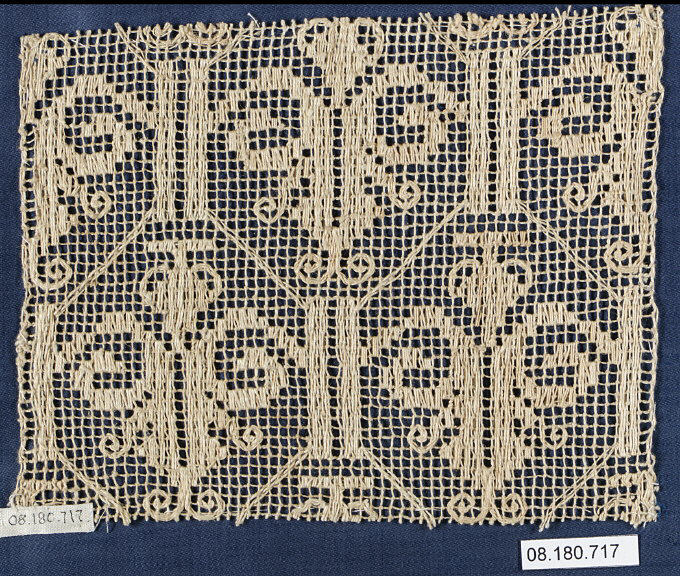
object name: fragment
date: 1801-1900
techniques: embroidery